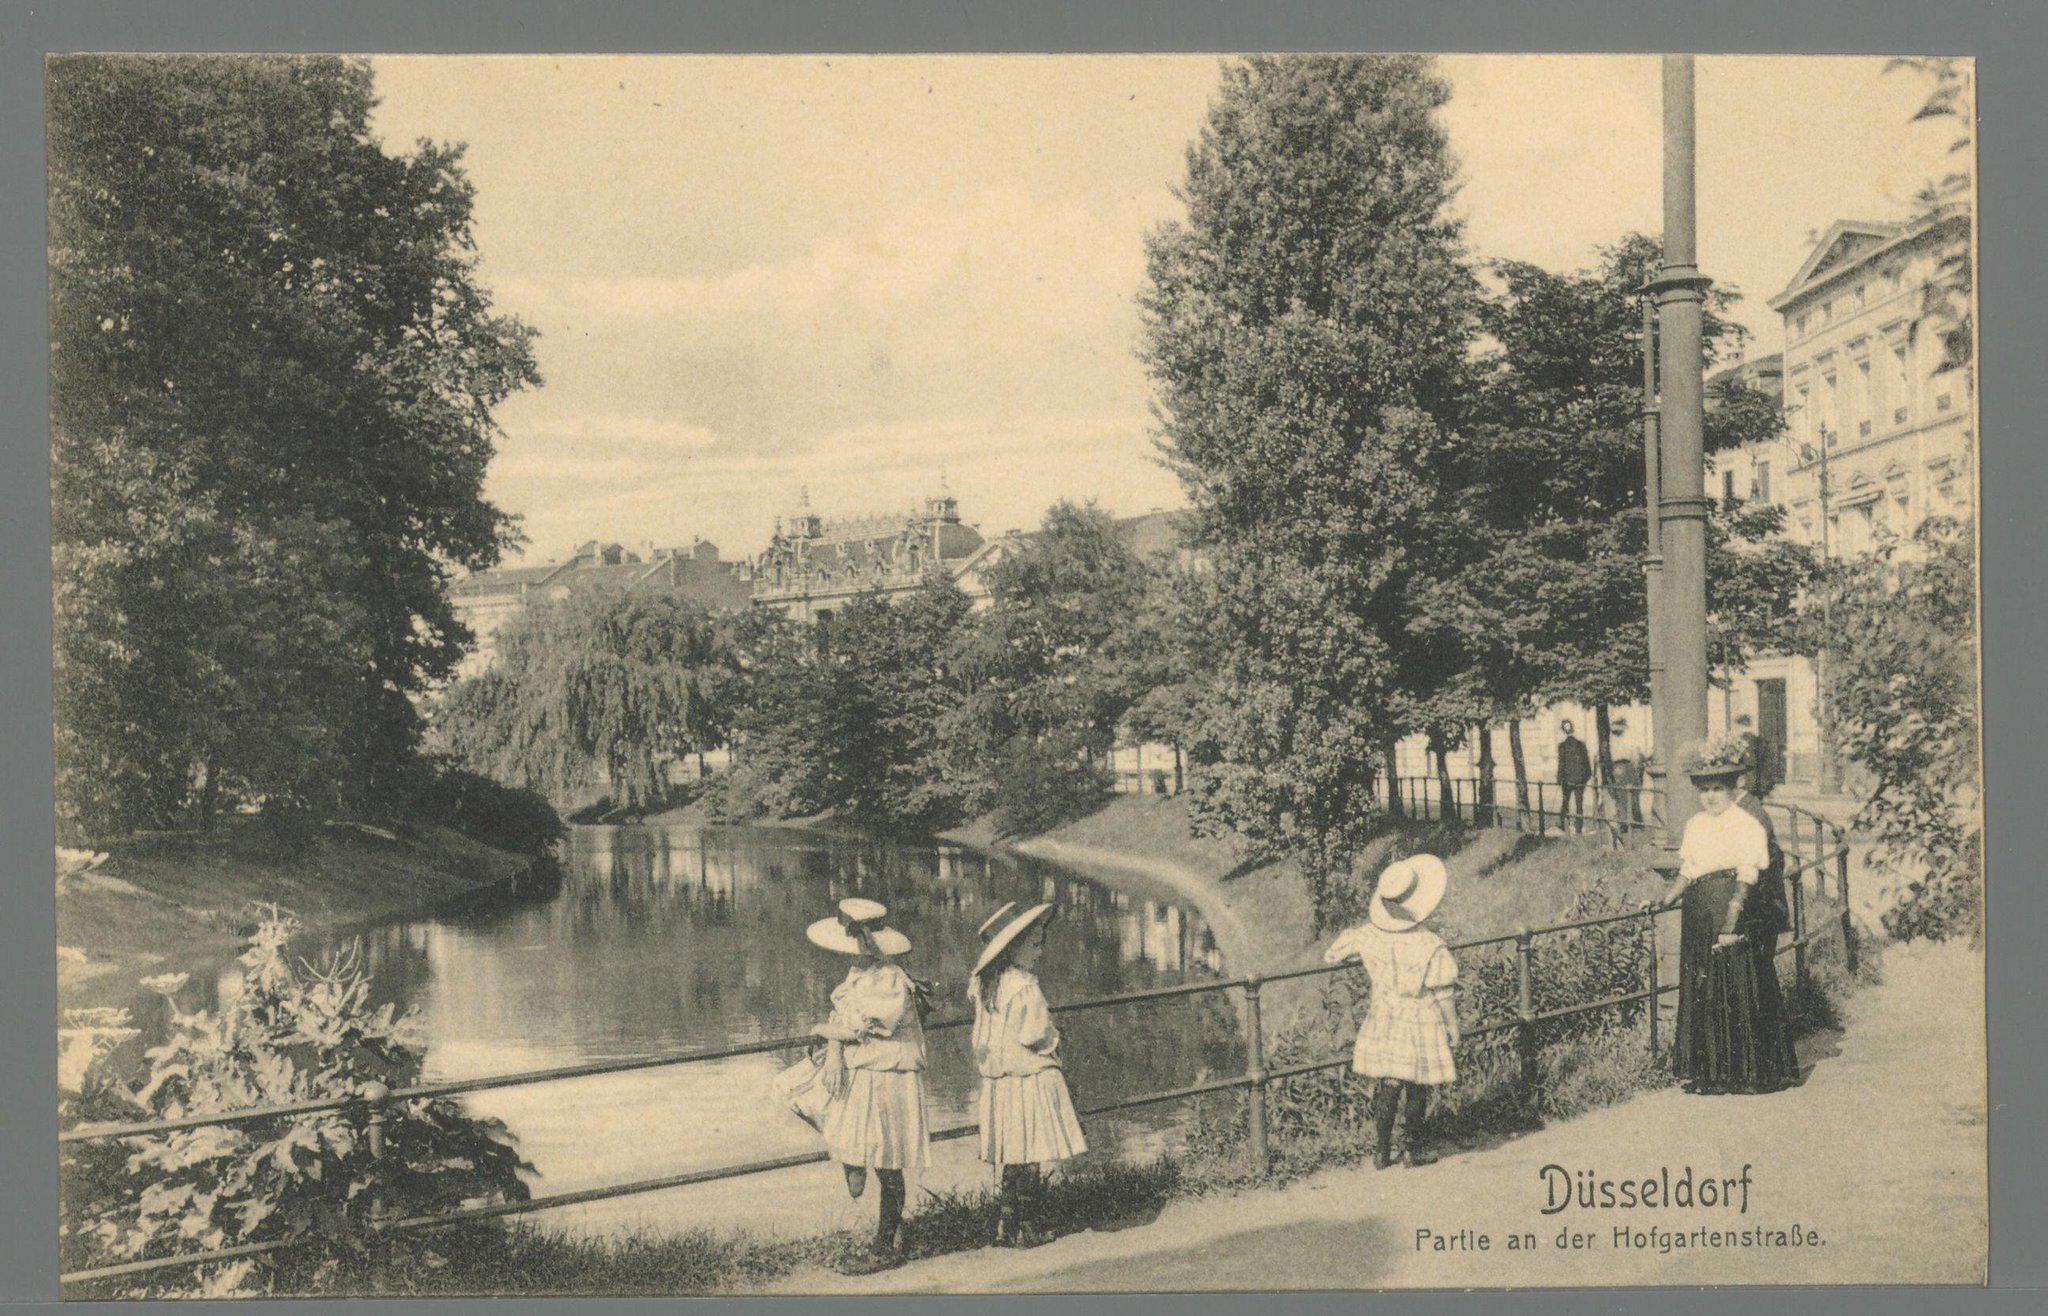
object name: ansichtkaart, prentbriefkaart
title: Düsseldorf. Partie an der Hofgartenstraβe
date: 1905-1930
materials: cardboard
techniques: photograph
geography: dusseldorf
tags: park, pond